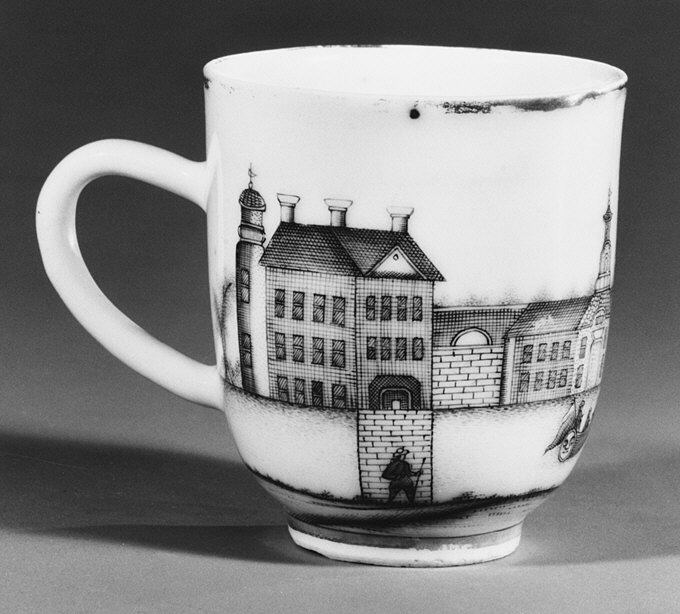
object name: cup and saucer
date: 1735-1740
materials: hard paste porcelain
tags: human figures,buildings,boats